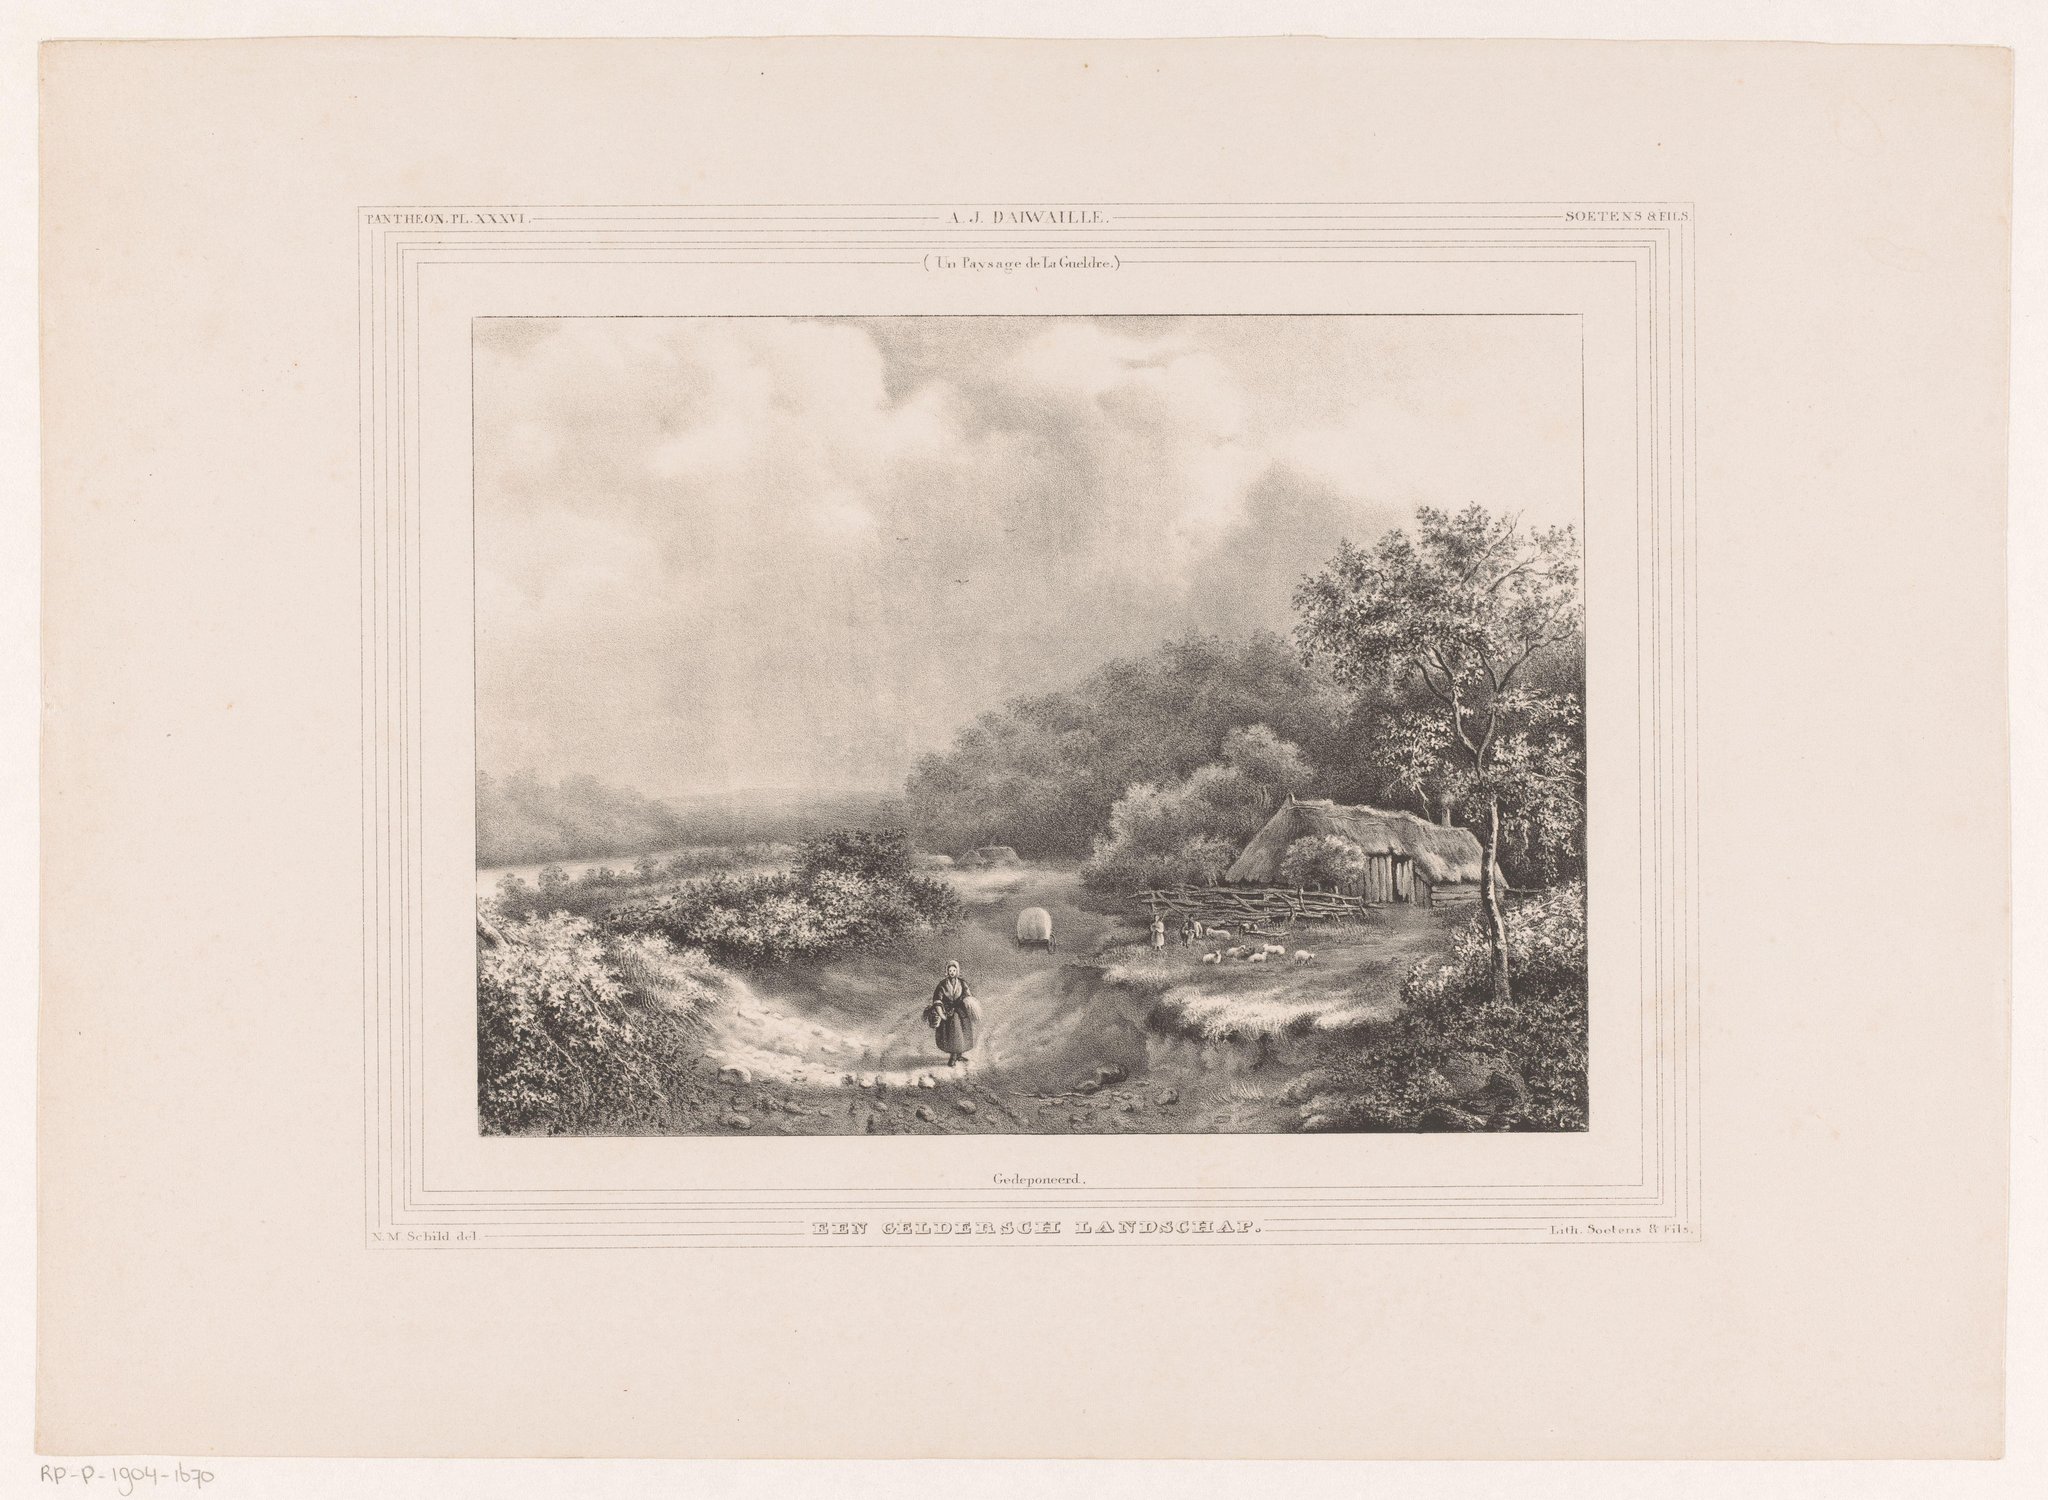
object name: print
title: Un Paysage de La Gueldre / Een Geldersch landschap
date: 1837-1840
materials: paper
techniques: lithograph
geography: the hague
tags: landscapes (+ landscape with figures, staffage), gelderland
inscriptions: collector's mark: Lugt 2228, : ‘Gedeponeerd.’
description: Een vrouw met mand loopt over een pad in een Gelders landschap. Rechts twee kinderen met schapen voor een boerderij. In de achtergrond een hooiwagen, huizen en links een rivier. Links boven genummerd PL. XXXVL.